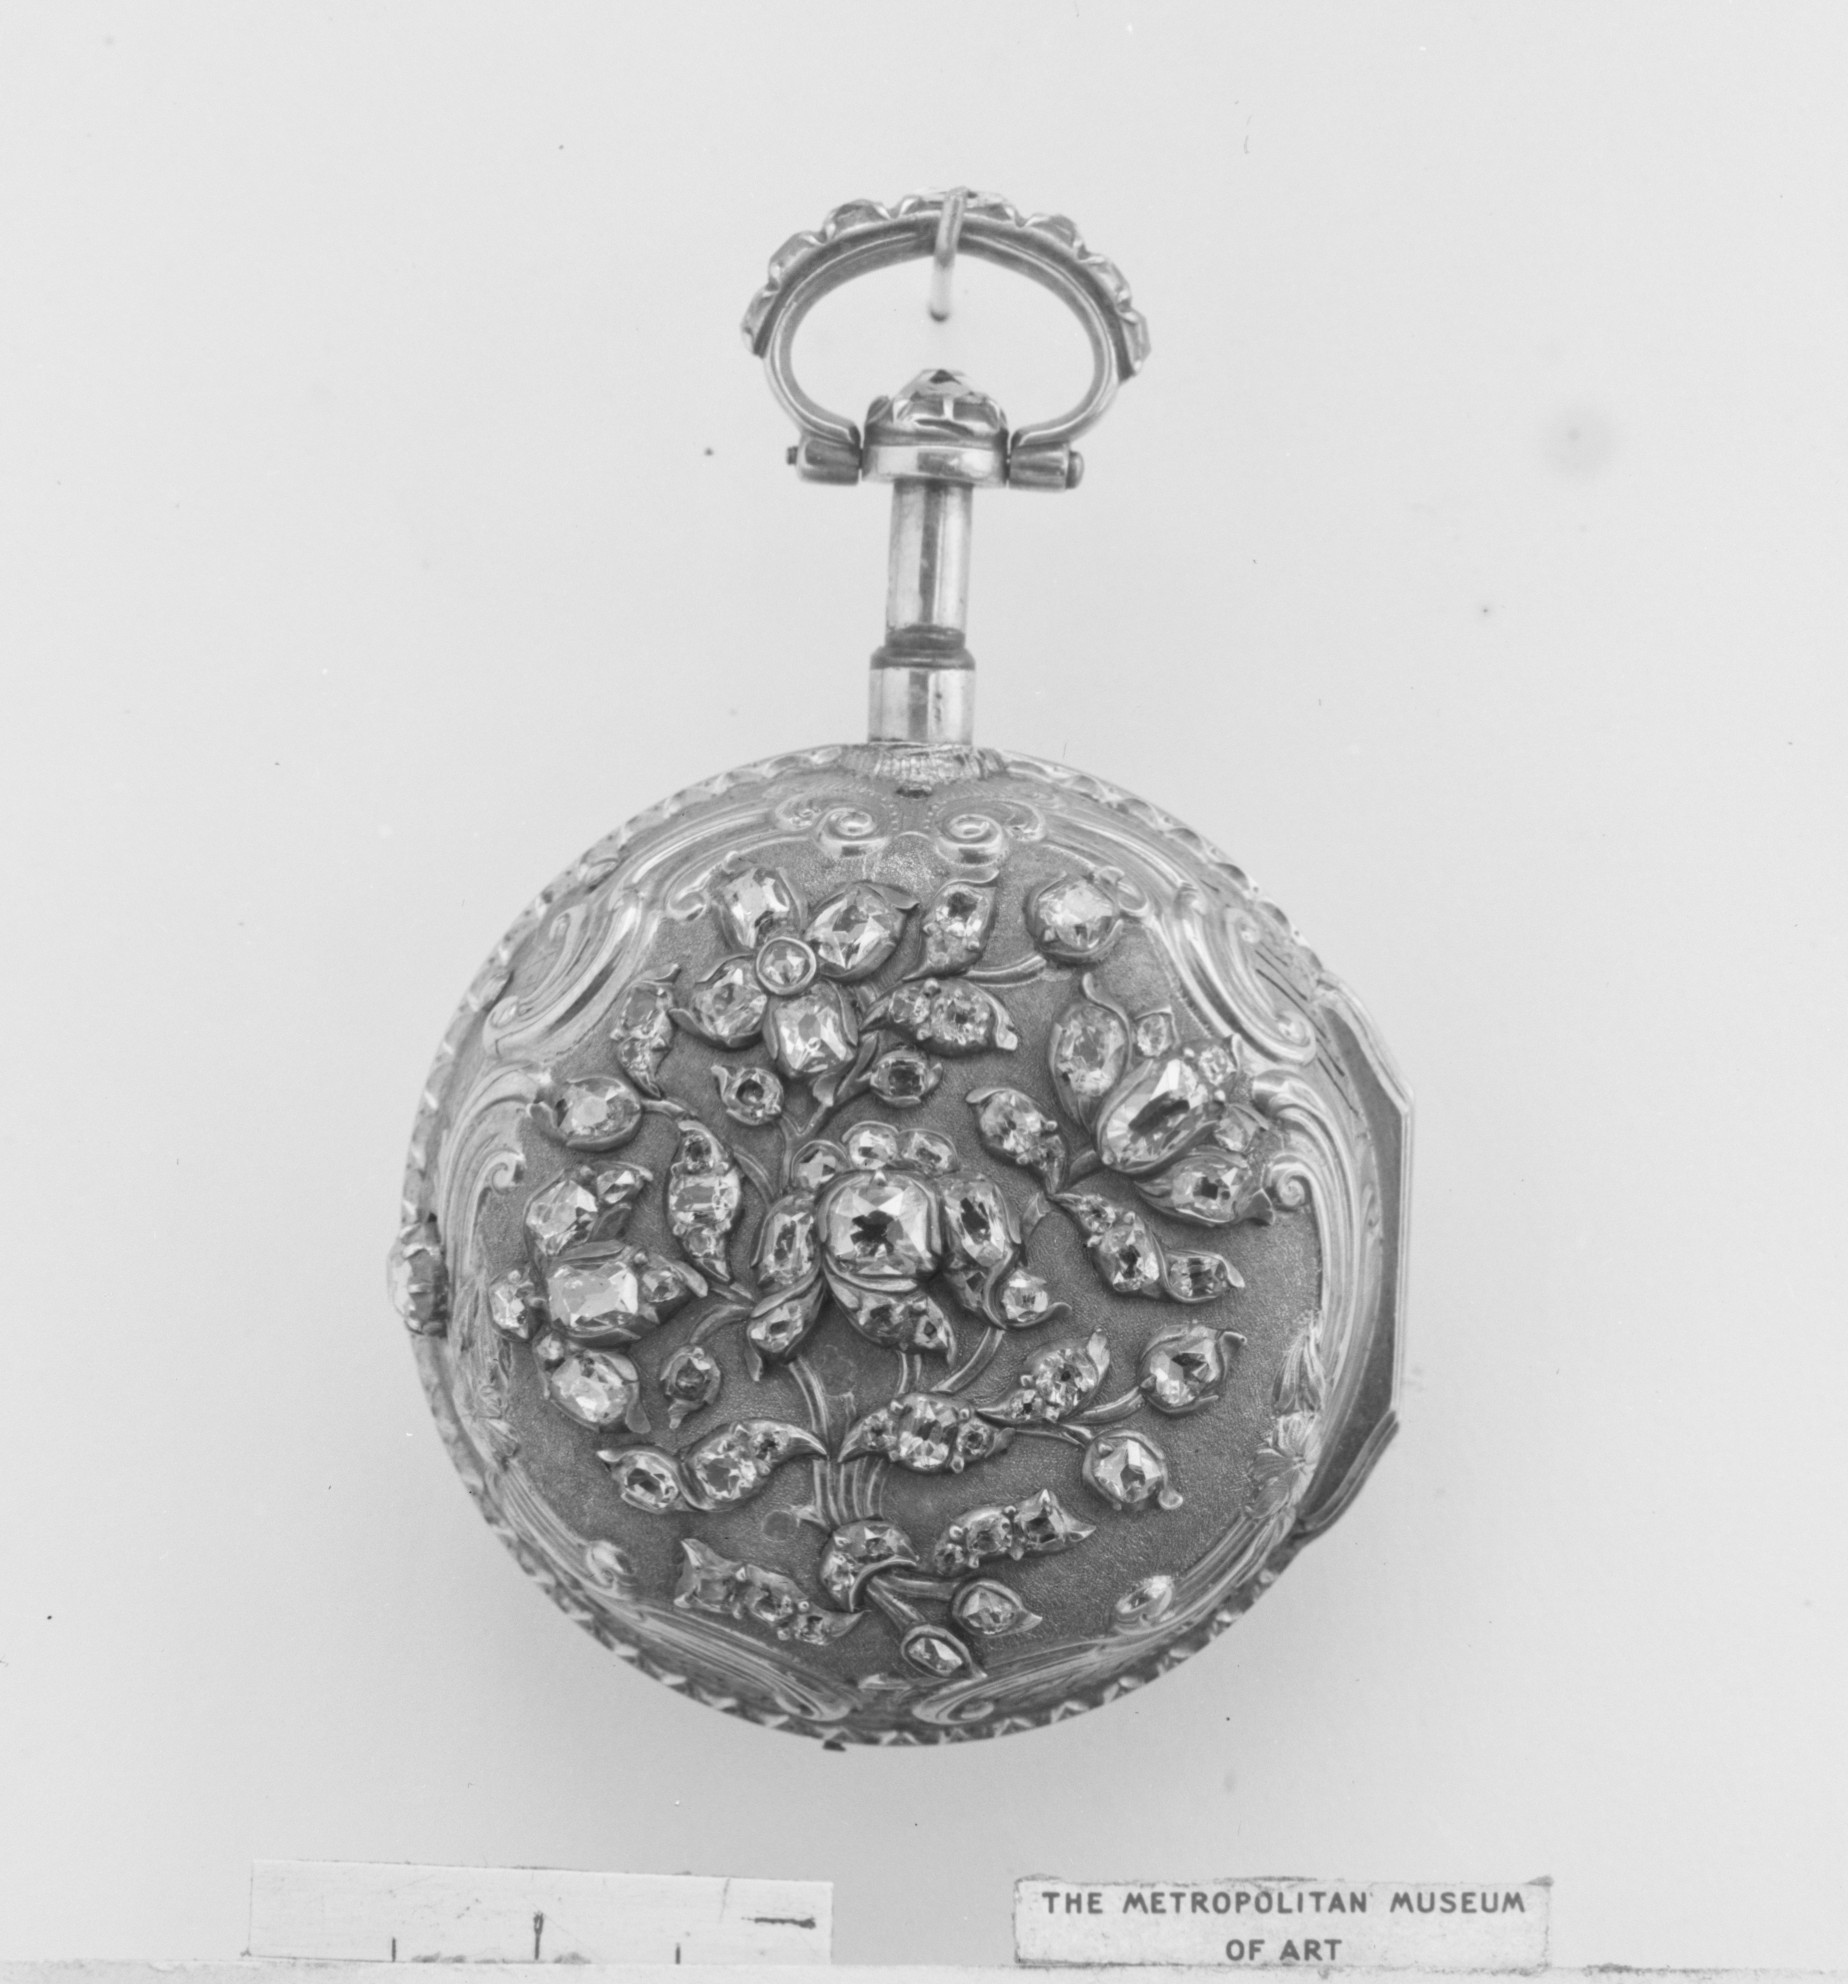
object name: repeater watch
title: Quarter repeater watch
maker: jean baptiste dutertre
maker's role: maker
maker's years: 1715-1742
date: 1750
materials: diamond, gemstone, gold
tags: flowers